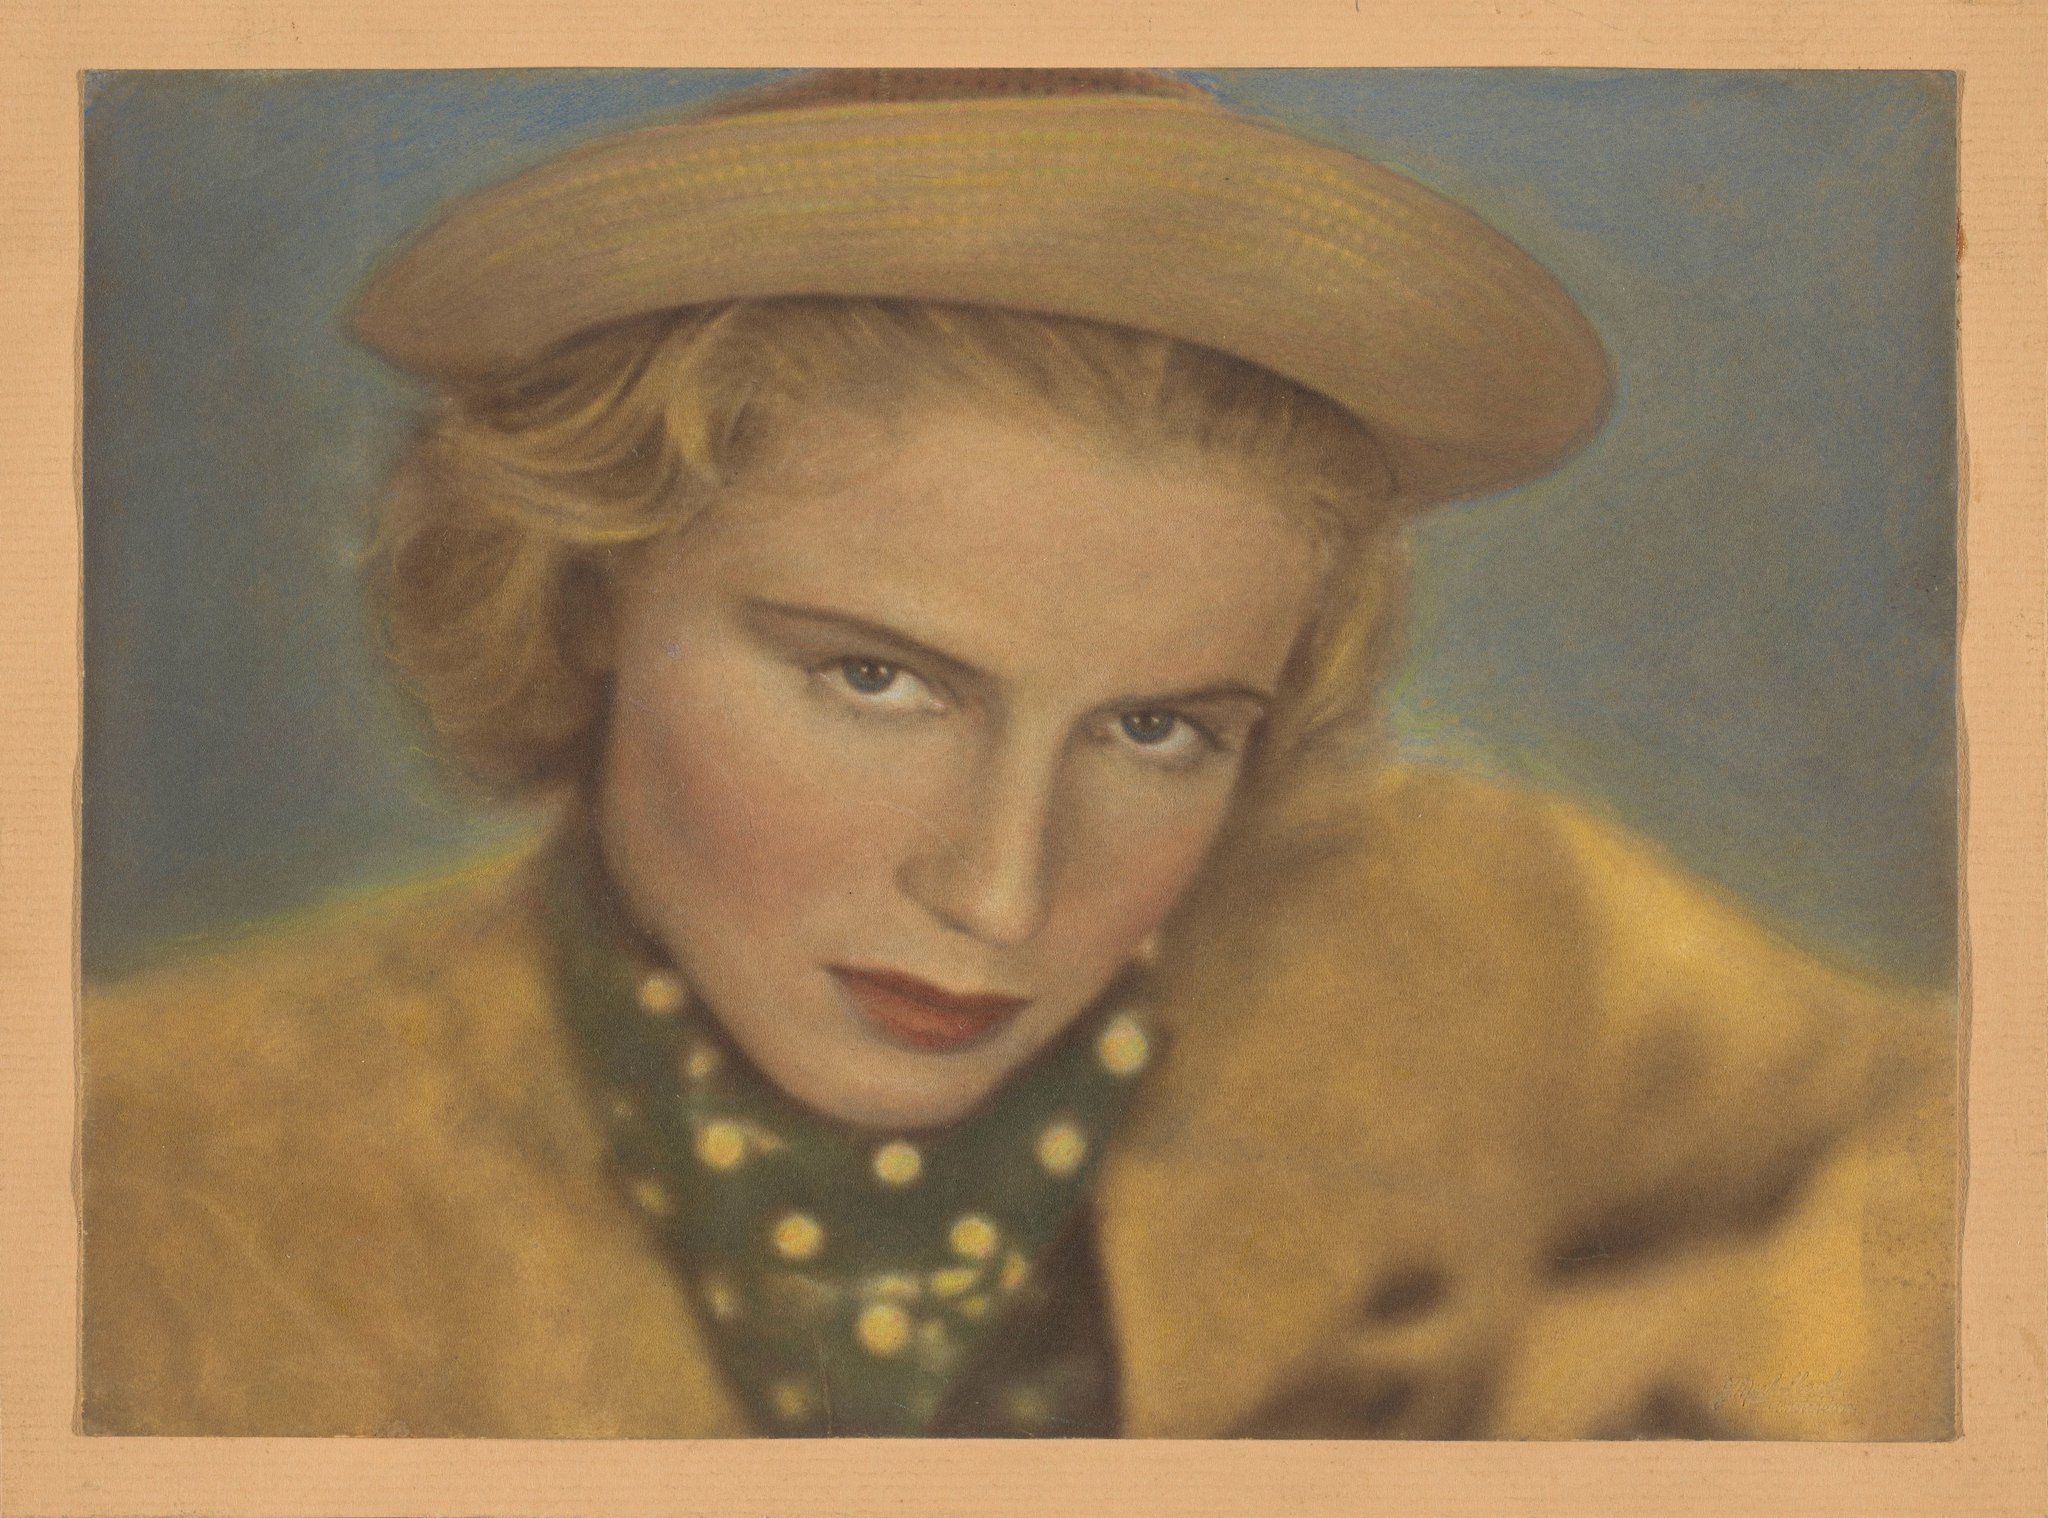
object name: photograph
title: Portret Rini Otte met hoed en noppensjaal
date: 1940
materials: cardboard, photographic support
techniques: gelatin silver print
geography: amsterdam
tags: historical persons (portraits and scenes from the life) - bb - woman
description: Portret Rini Otte met hoed en noppensjaal voor "Ergens in Nederland".